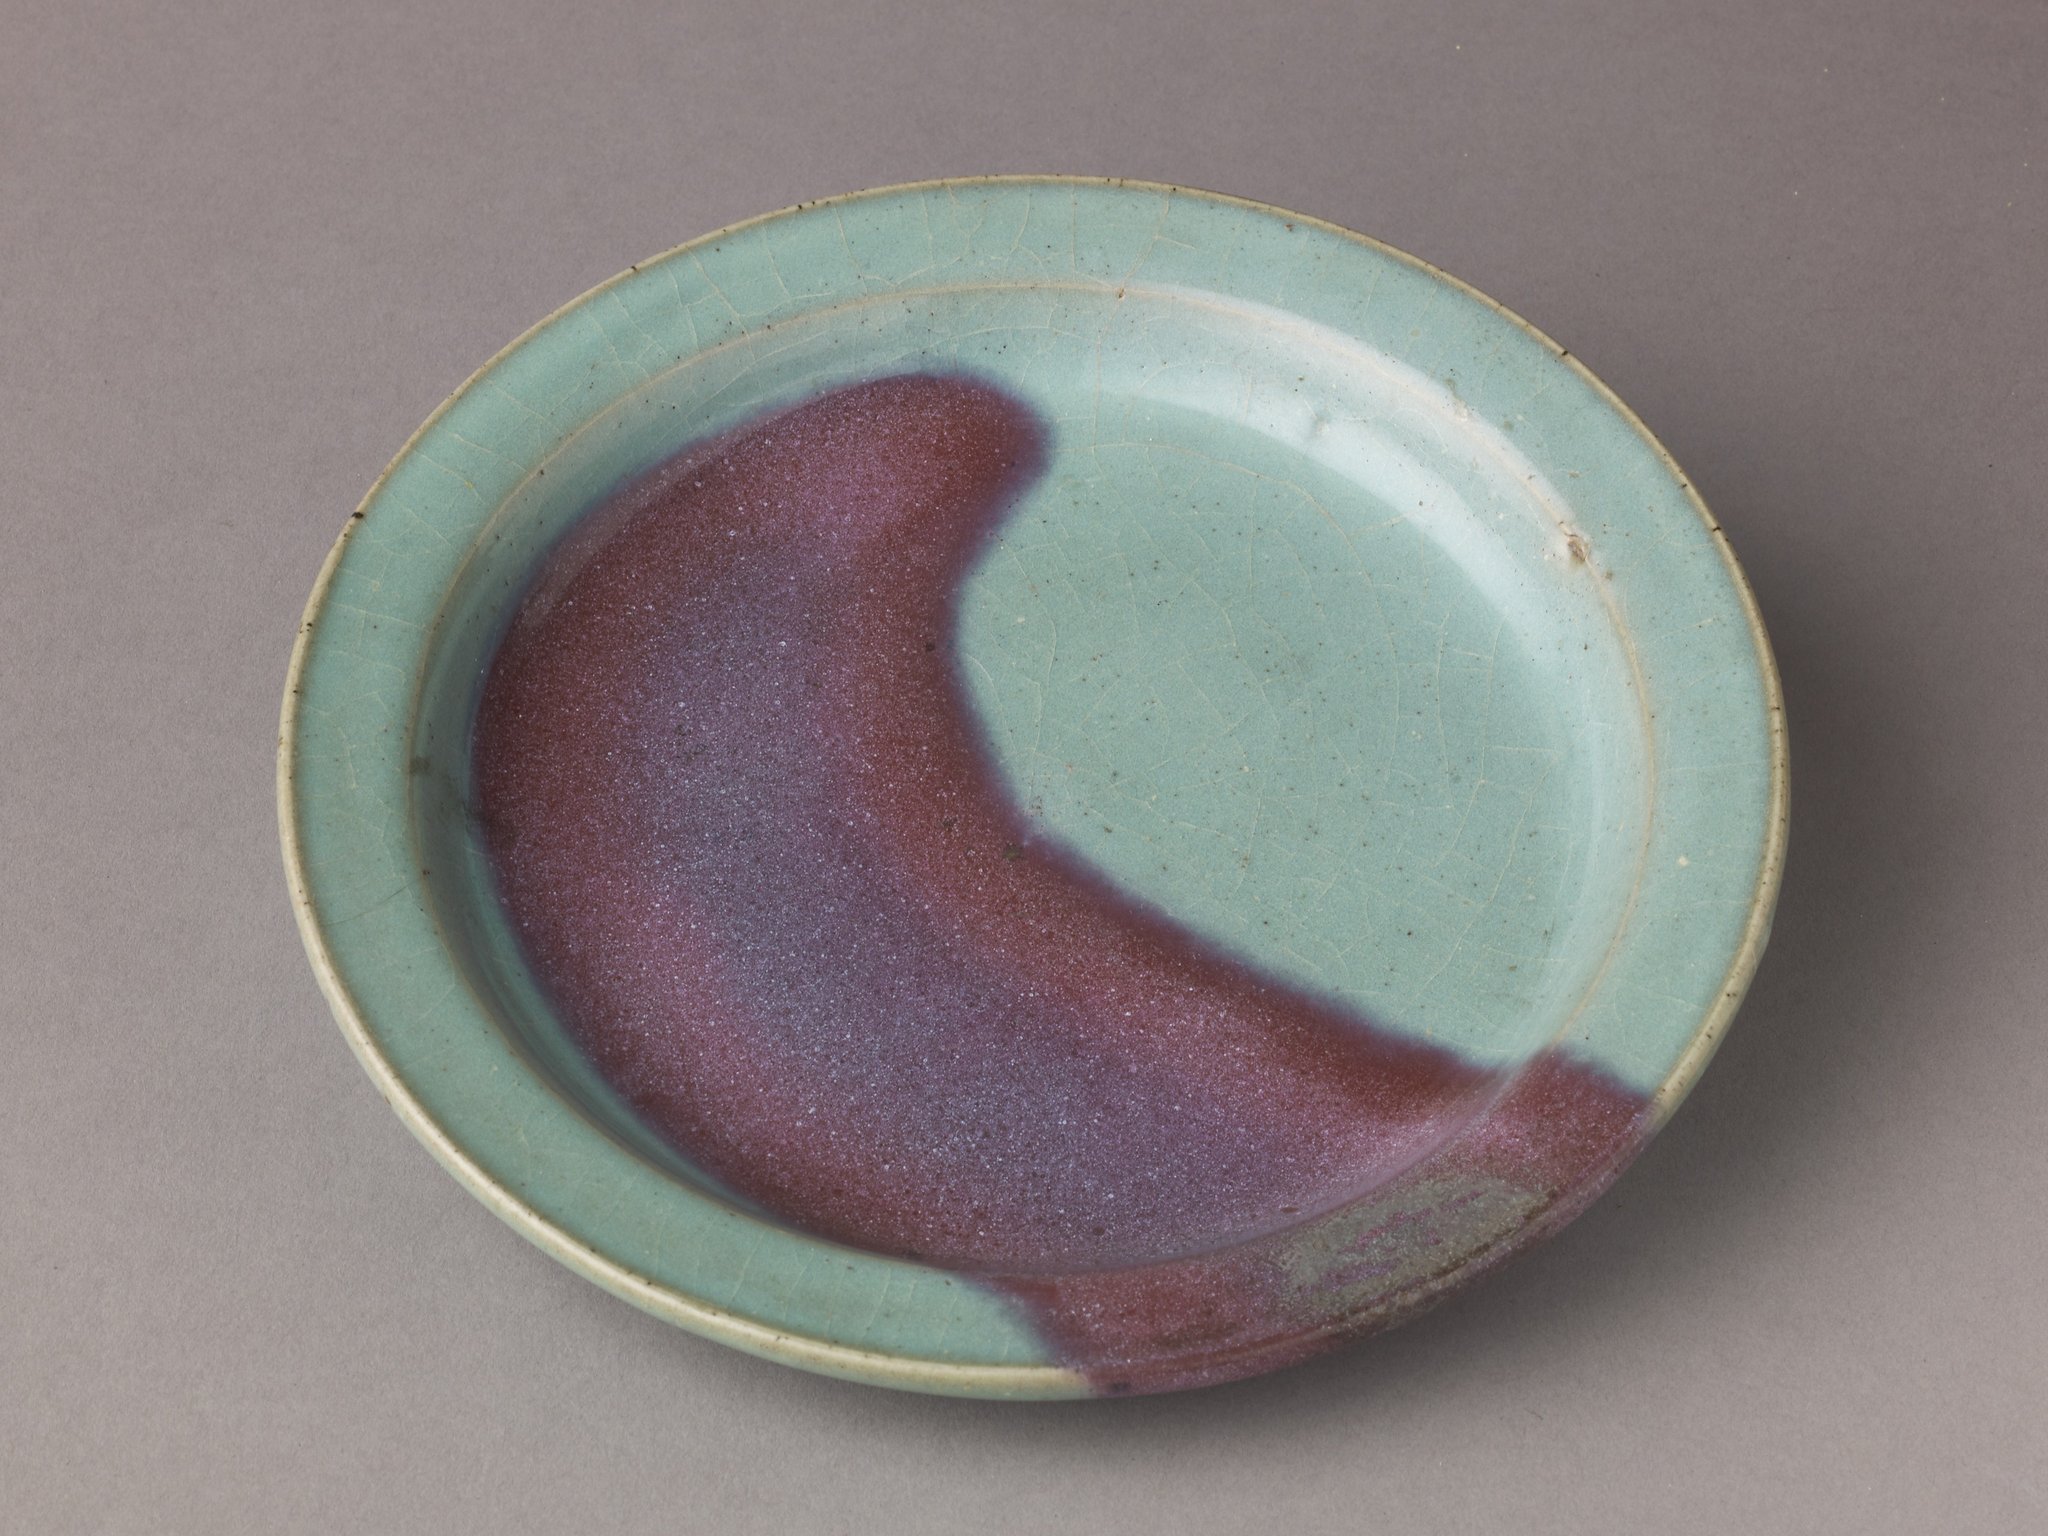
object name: plate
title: Plate, Jun ware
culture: chinese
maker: chinese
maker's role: artist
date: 1101-1300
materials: glaze, stoneware